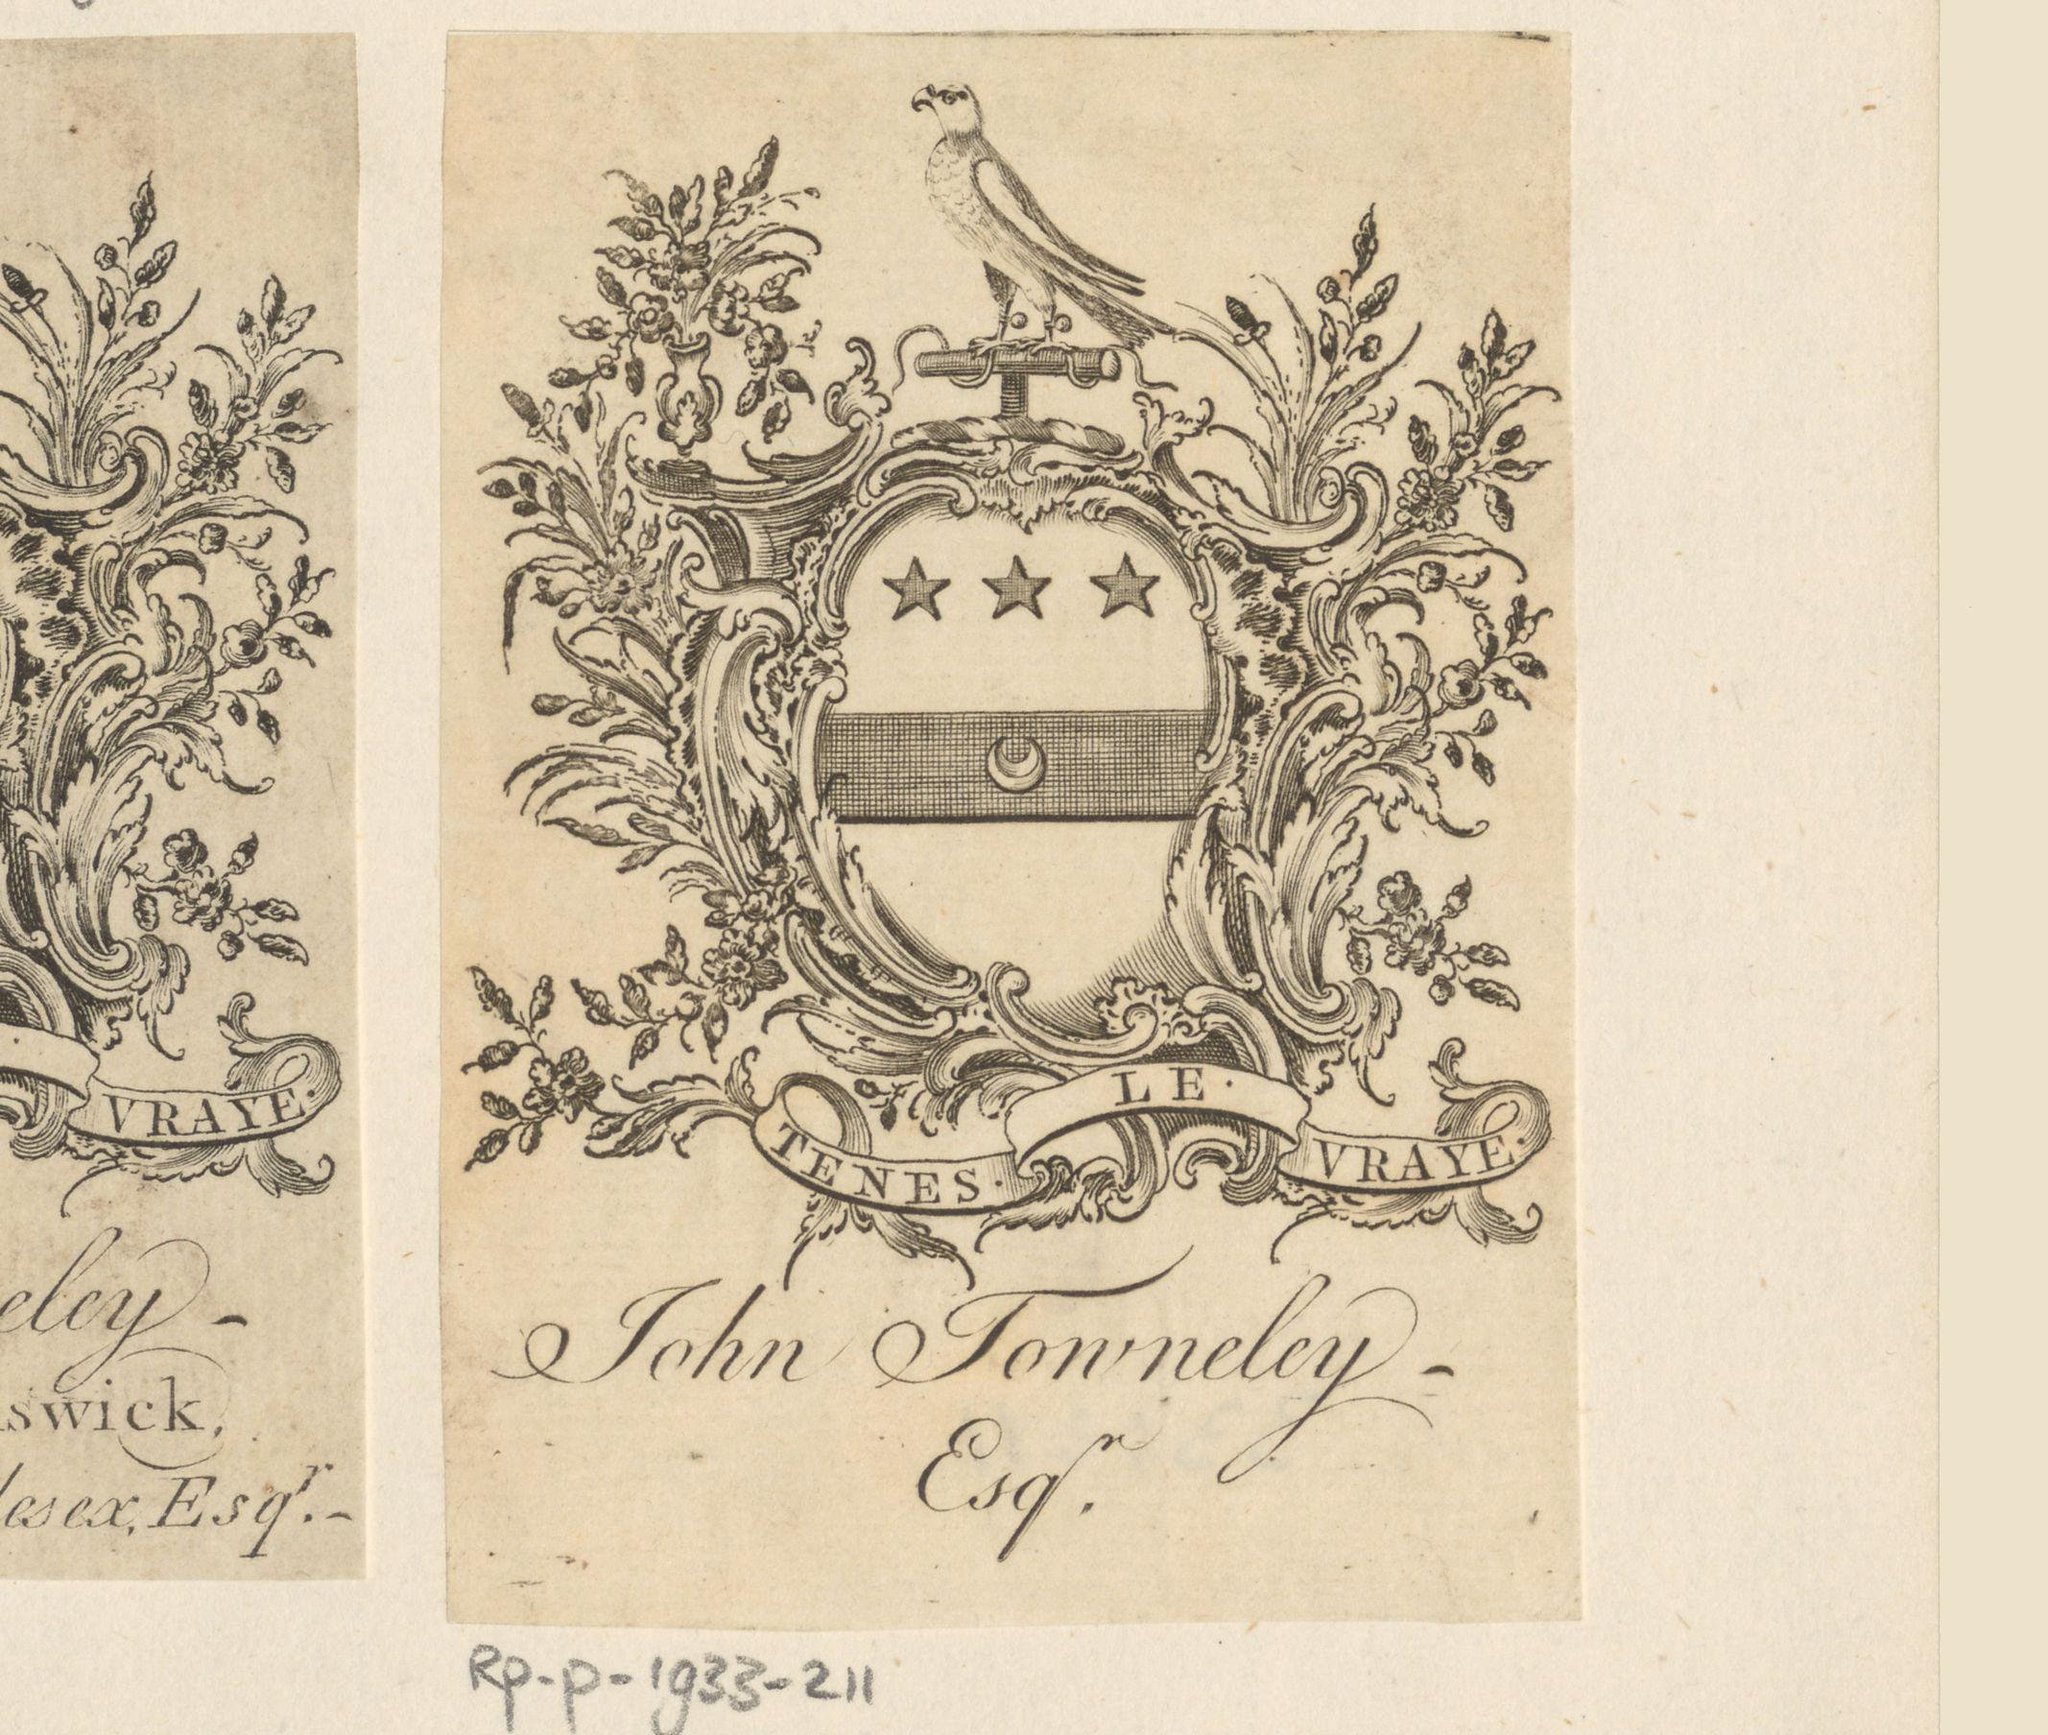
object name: bookplate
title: Tenes le vraye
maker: Anonymous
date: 1741-1813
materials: paper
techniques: engraving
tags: armorial bearing, heraldry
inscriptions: collector's mark: Lugt 2760